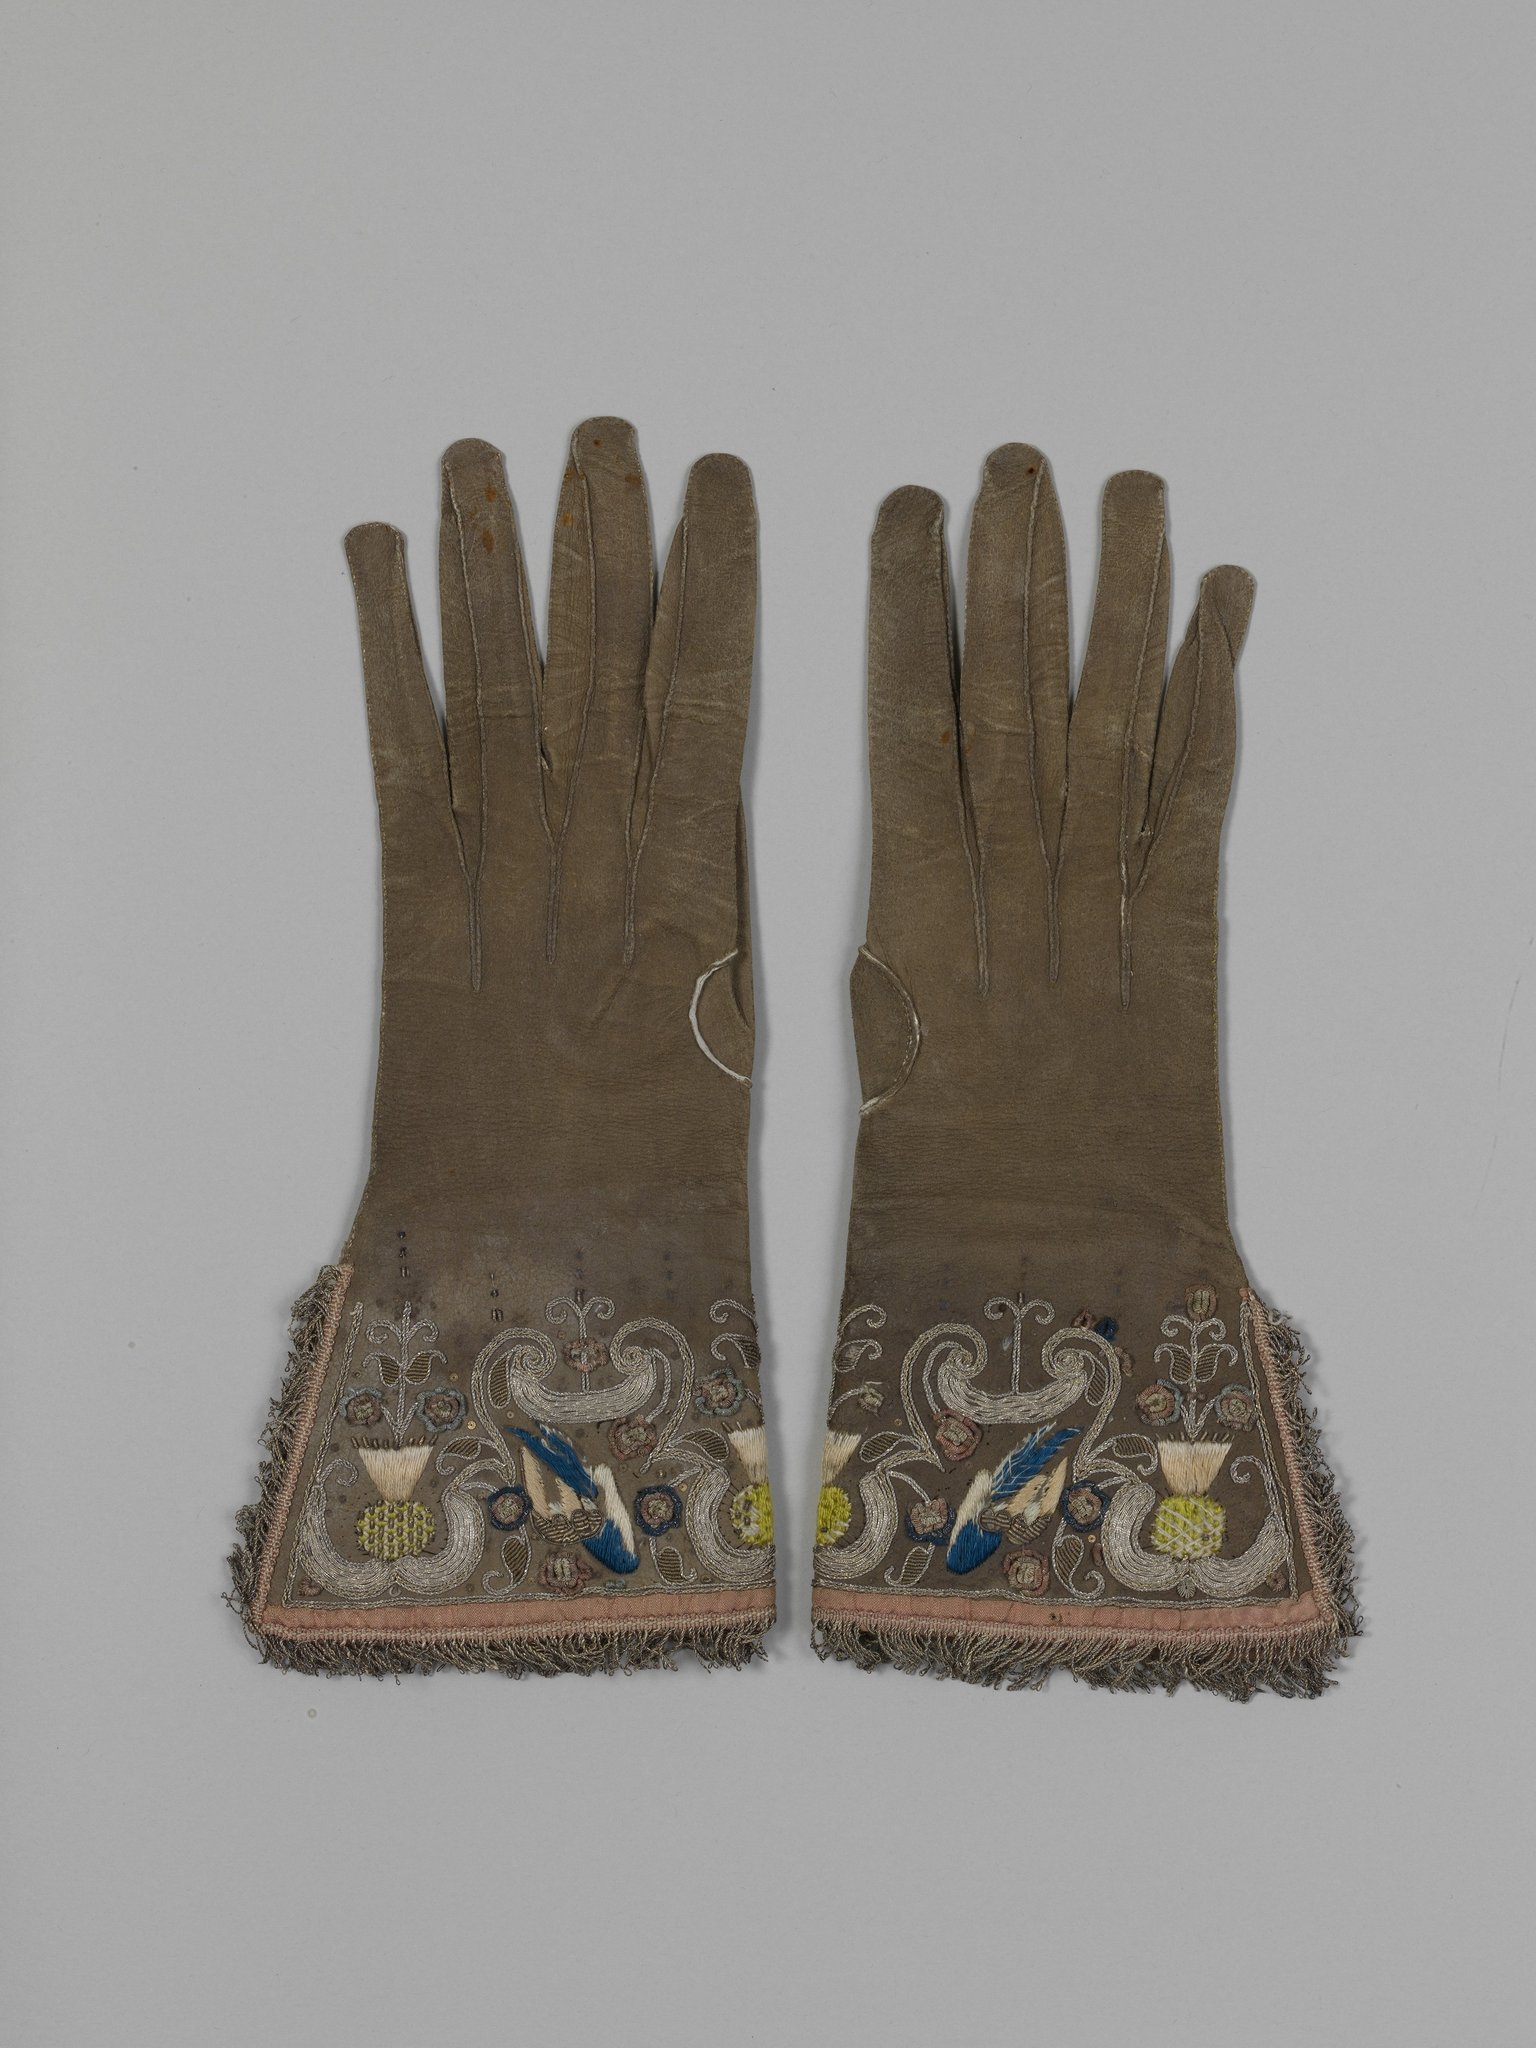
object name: glove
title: Pair of gloves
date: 1620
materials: leather, metal thread, silk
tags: flowers